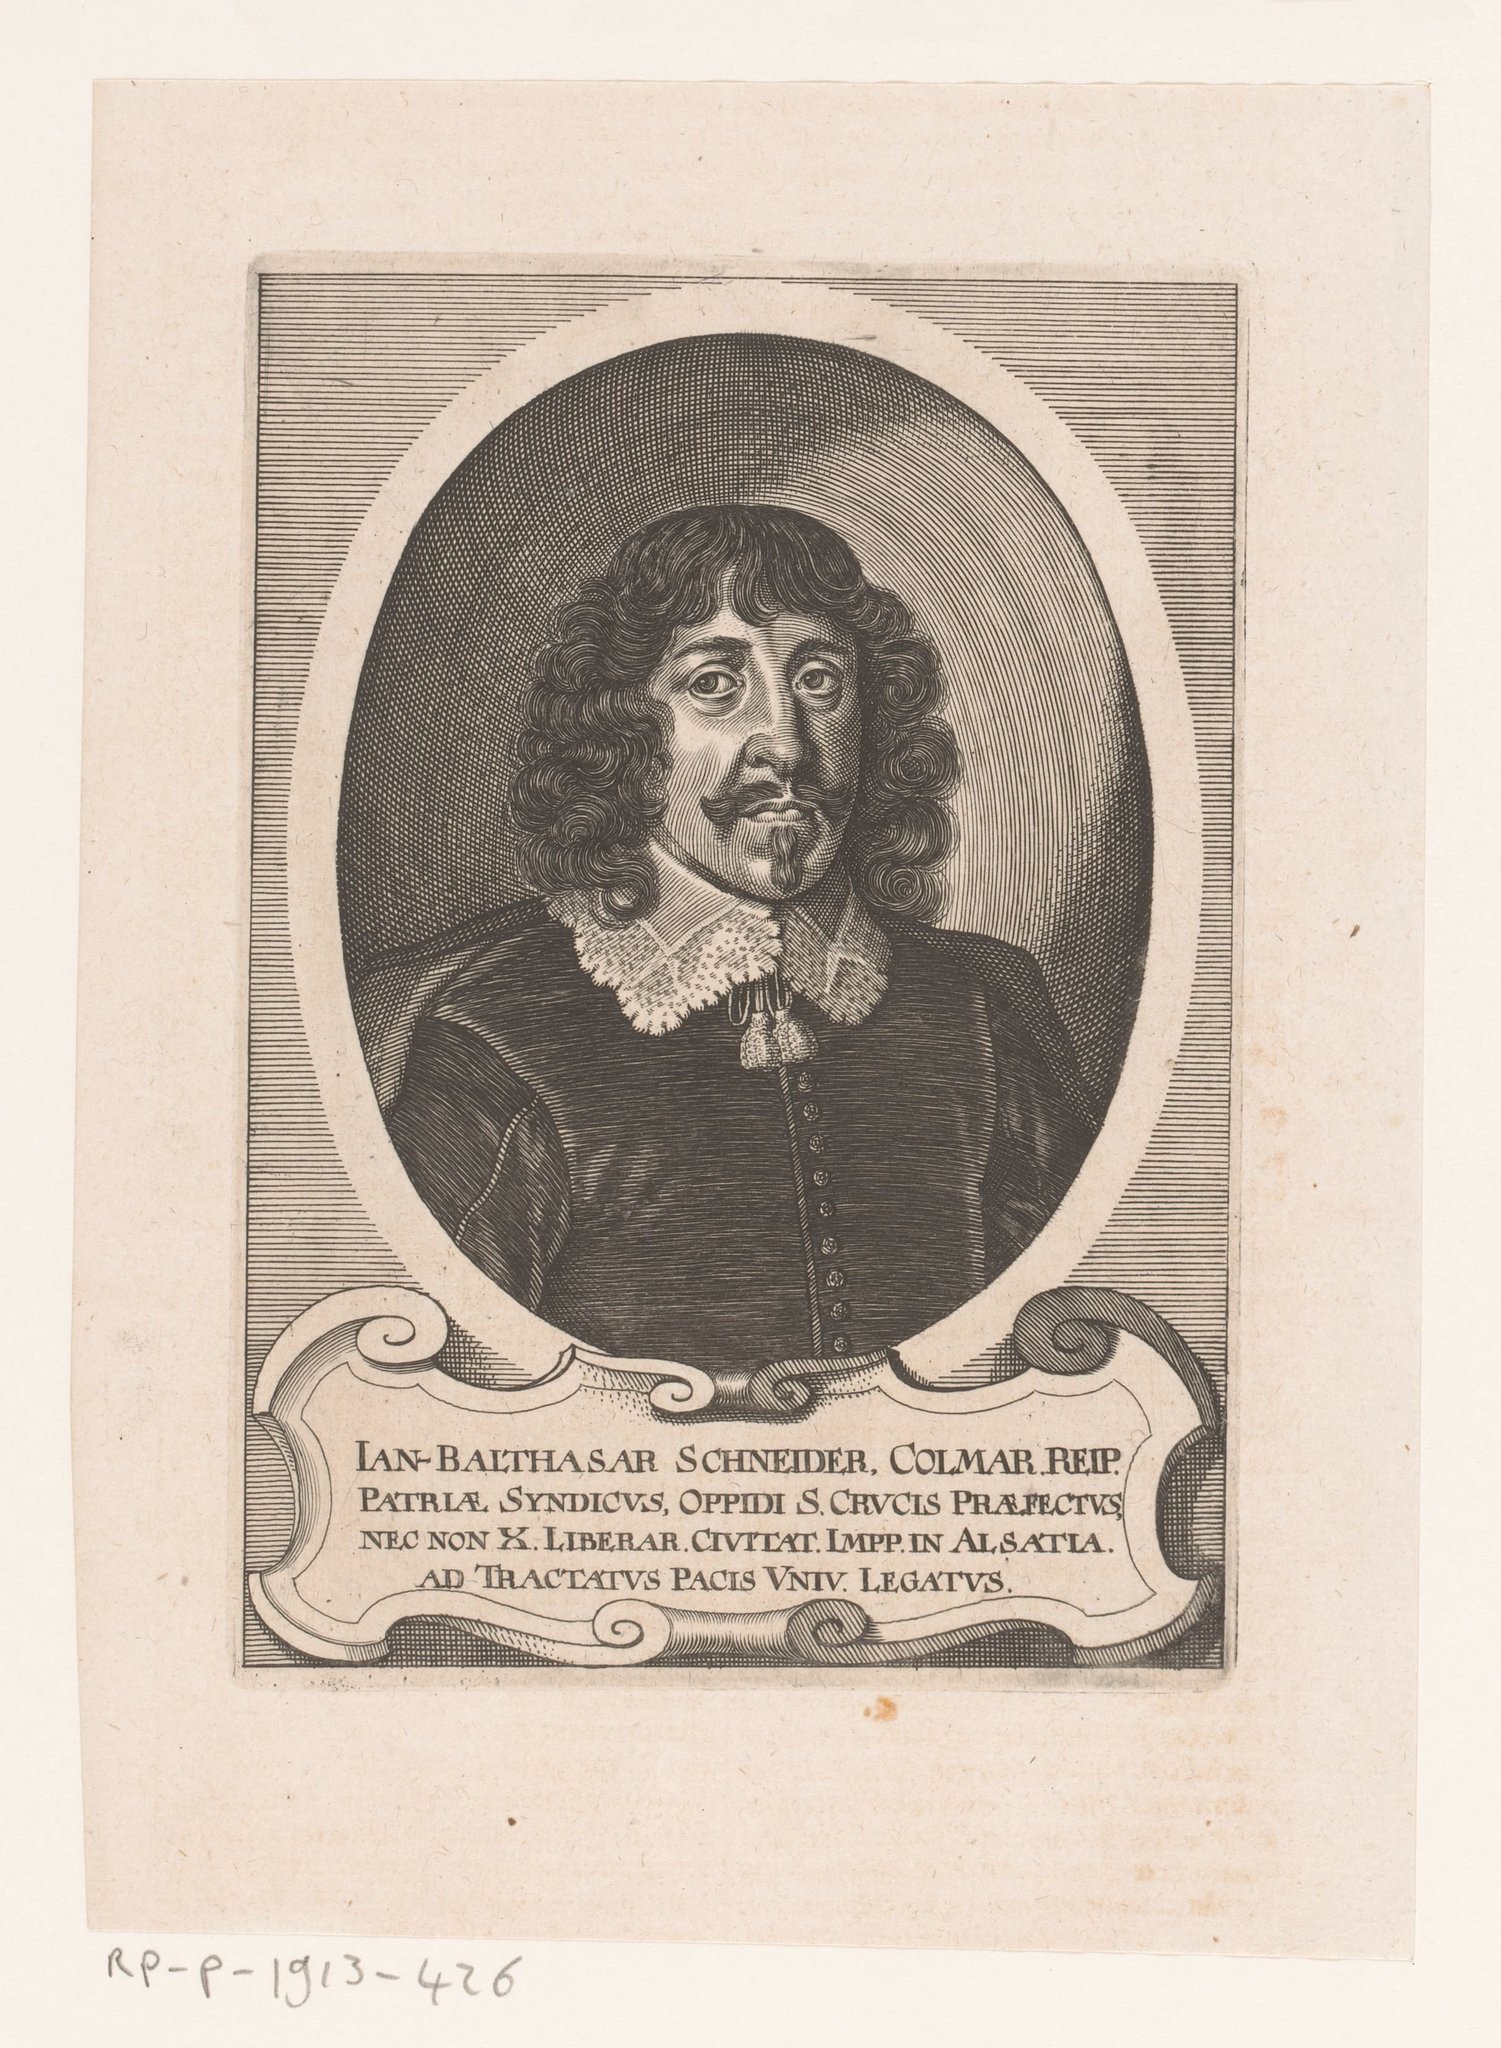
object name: book illustration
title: Portret van Johann Balthasar Schneider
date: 1652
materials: paper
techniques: engraving, etching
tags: historical persons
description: Illustratie in: J.G. Schleder. Theatrum Europaeum. Dl. 6. Frankfurt a.M., Merian, 1652. P. 664.